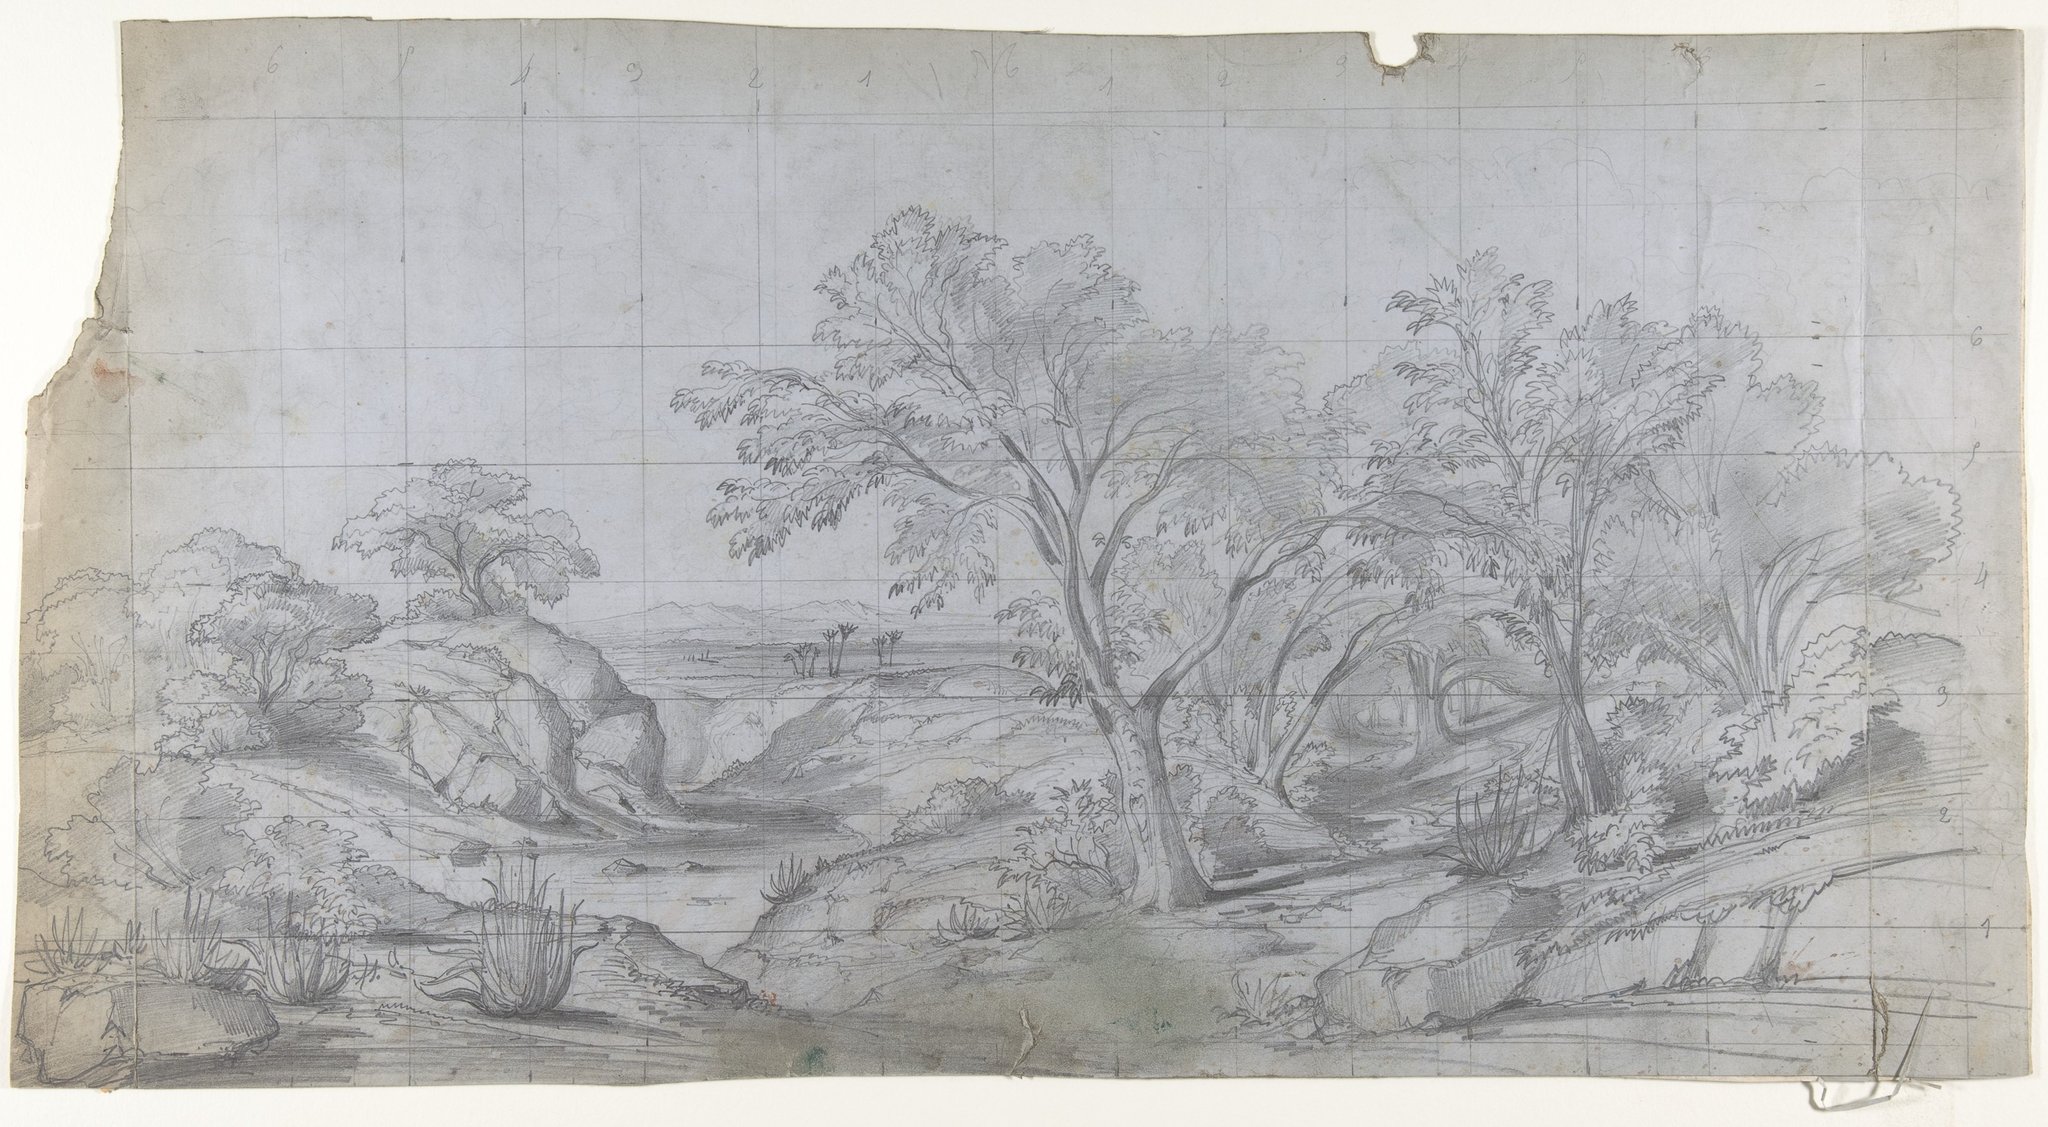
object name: drawing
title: Design for a Stage Set at the Opéra, Paris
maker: eugène cicéri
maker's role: artist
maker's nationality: french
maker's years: 1813-1890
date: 1828-1890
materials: graphite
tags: landscapes,stage design